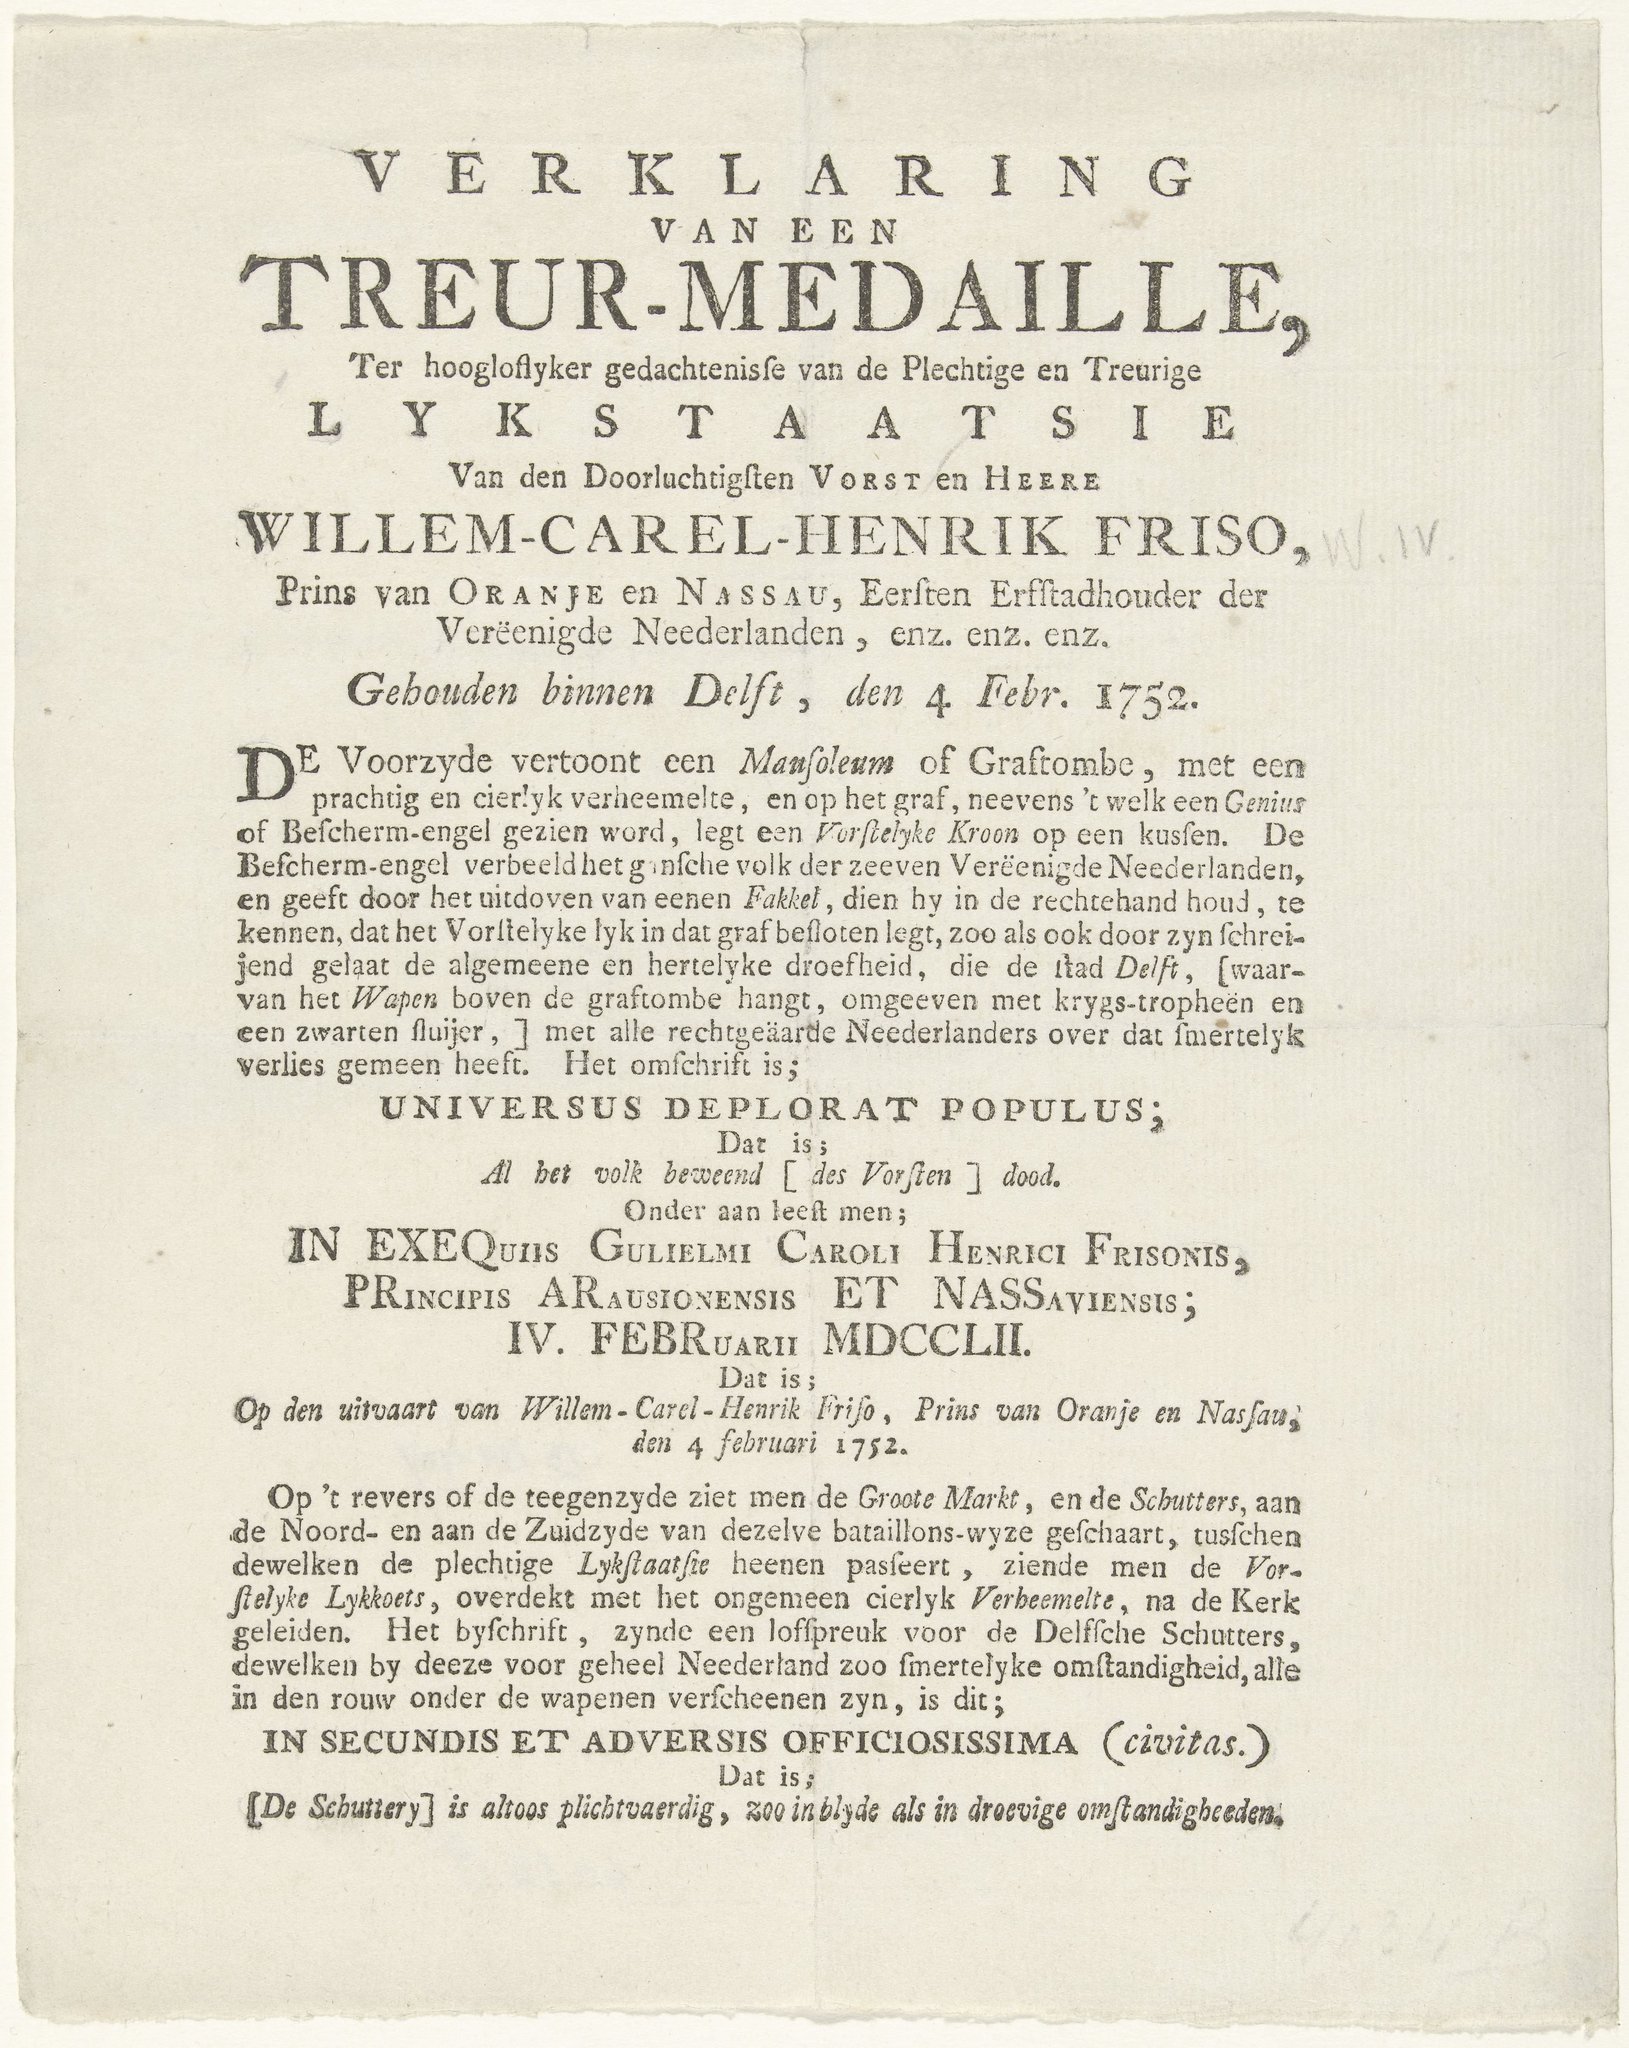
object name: text sheet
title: Verklaring van een Treur-medaille, Ter hoogloflyker gedachtenisse van de Plechtige en Treurige Lykstaatsie (...) Willem-Carel-Henrik-Friso (...) Gehouden binnen Delft, den 4. Febr. 1752.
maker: Anonymous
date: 1752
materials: paper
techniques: letterpress printing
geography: northern netherlands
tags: the hague, willem iv (prins van oranje-nassau), delft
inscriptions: collector's mark: Lugt 2228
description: Tekstblad met de beschrijving van de voorstellingen op de beide zijden van een penning of treurmedaille geslagen ter gelegenheid van de begrafenis van stadhouder Willem IV op 4 februari 1752 te Delft. Betreft waarschijnlijk de zilveren penning van Nicolaas van Swinderen uitgedeeld aan de leden van de Delftse schutterij.